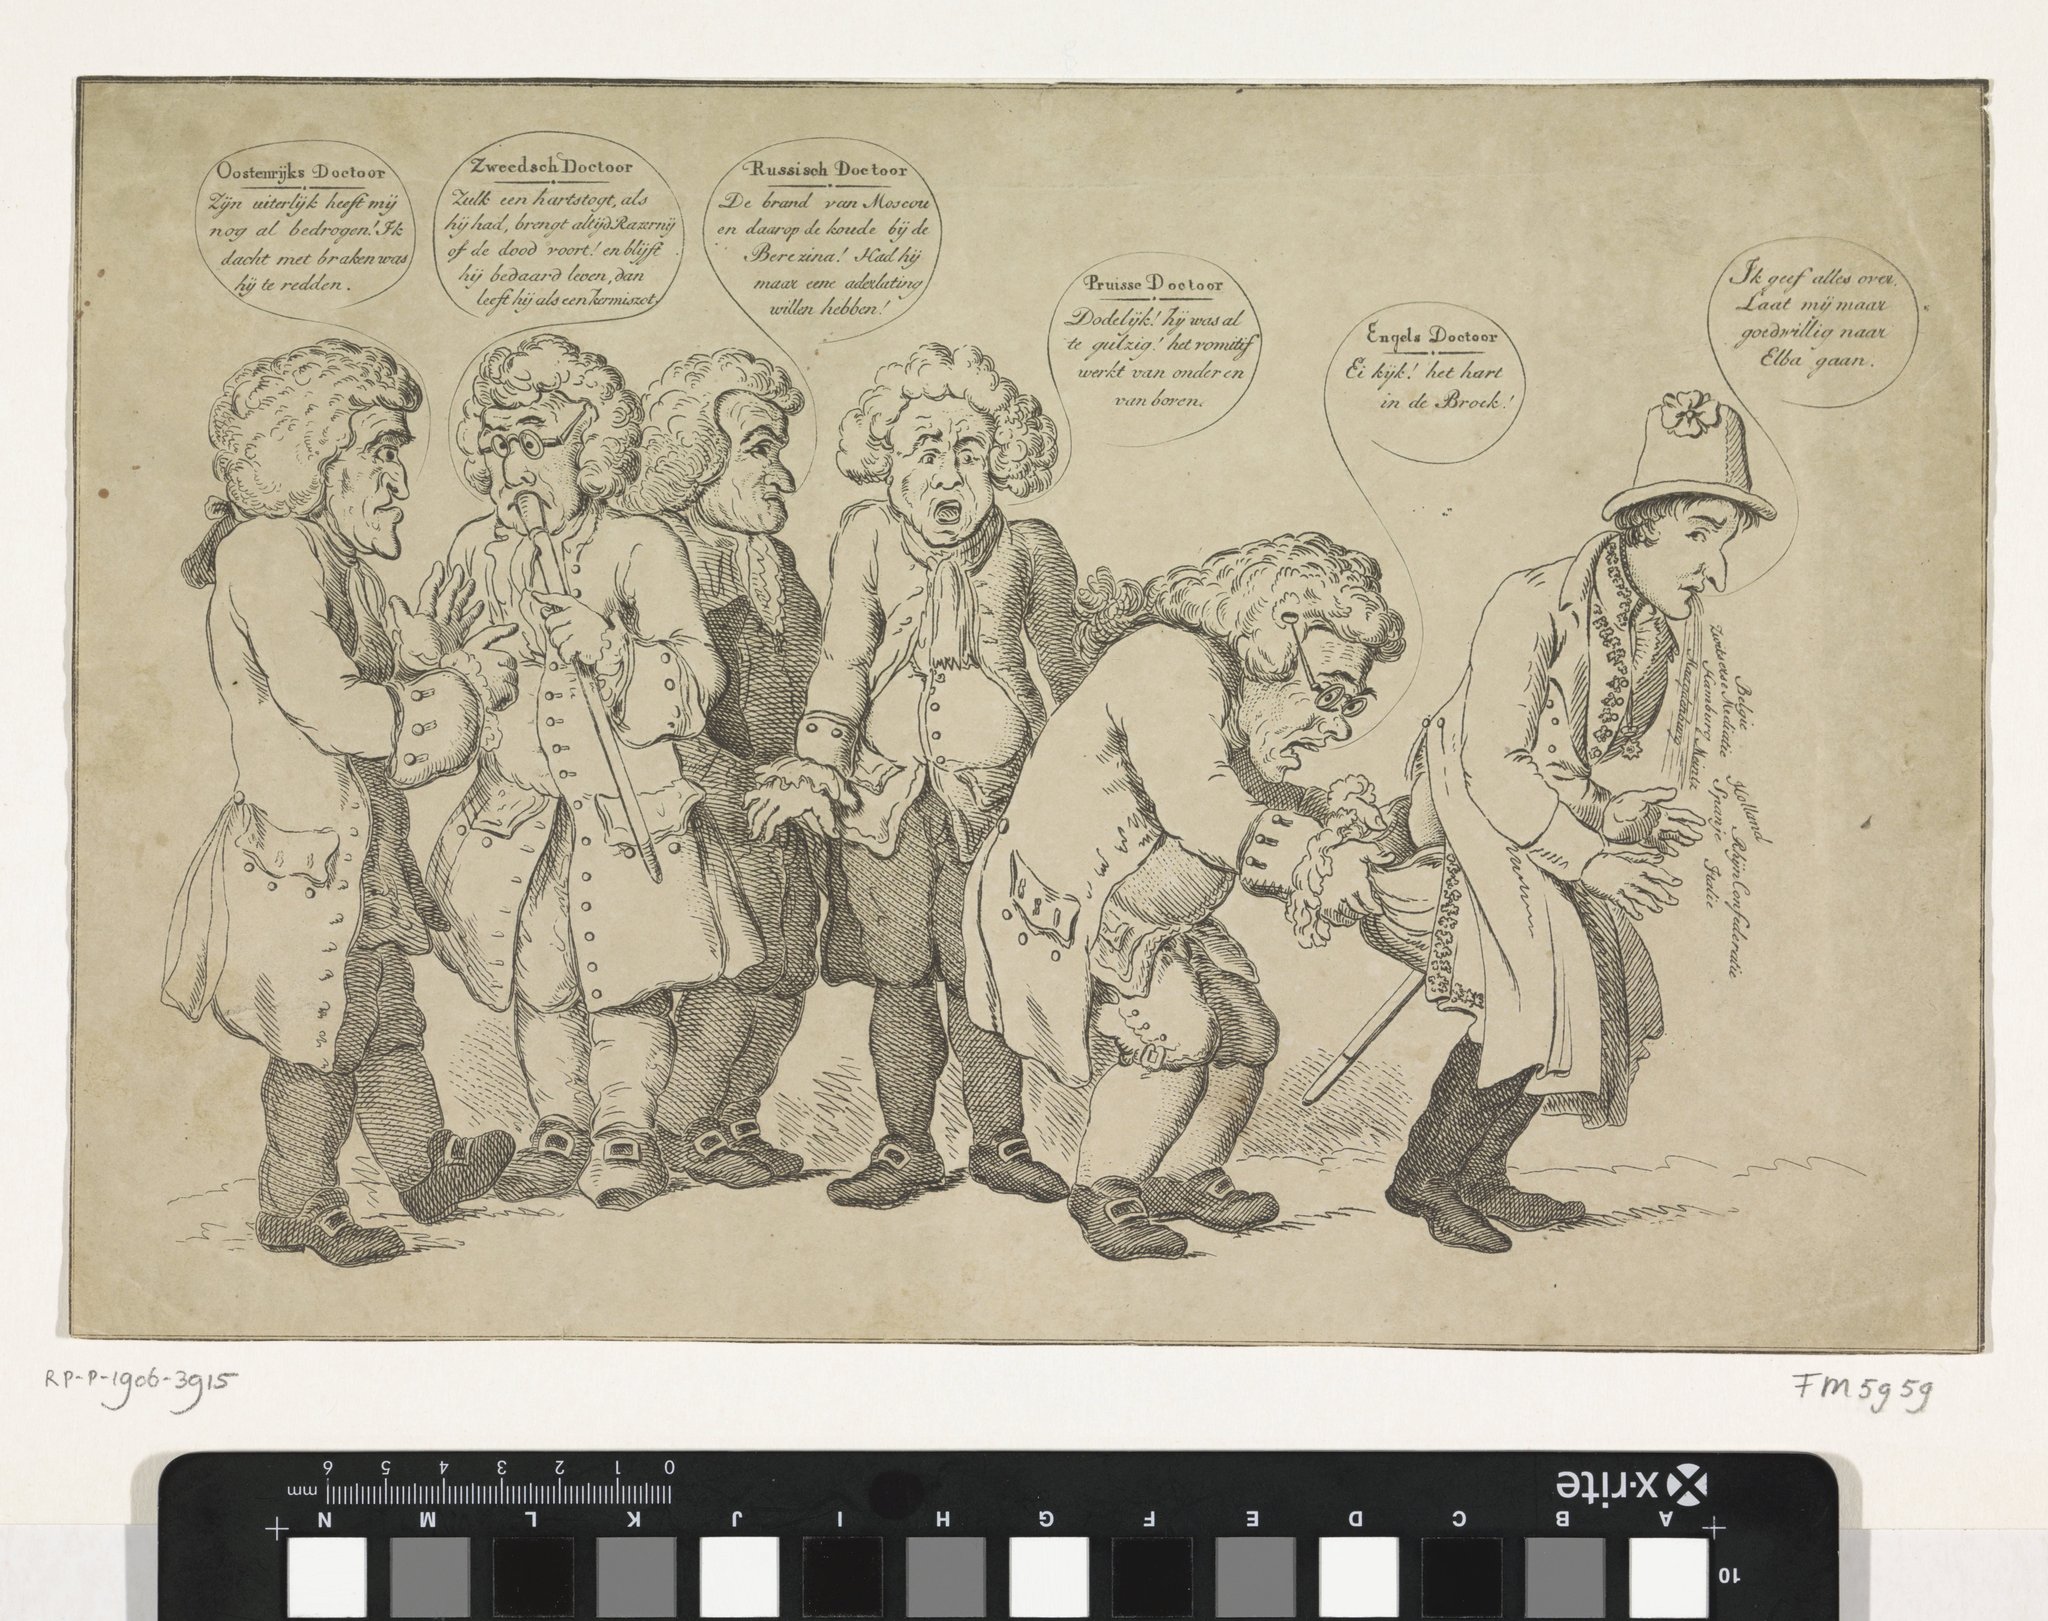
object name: cartoon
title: Napoleons in behandeling bij buitenlandse artsen, 1814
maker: Anonymous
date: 1814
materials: paper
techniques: engraving, etching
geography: netherlands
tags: napoleon i (emperor of the french), vomiting, examination, diagnosis; physician speaking with patient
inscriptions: collector's mark: Lugt 2228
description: Spotprent op Napoleons verbanning naar Elba, mei 1814. Napoleon wordt onderzocht door verbaasd kijkende dokters uit de geallieerde landen: Engeland, Pruisen, Rusland, Zweden en Oostenrijk. De Engelse dokter kijkt in de achterzijde van de broek van Napoleon en merkt op 'Ei kijk! het hart in de broek!' Ondertussen braakt Napoleon de door hem veroverde gebieden, waaronder Holland, weer uit.